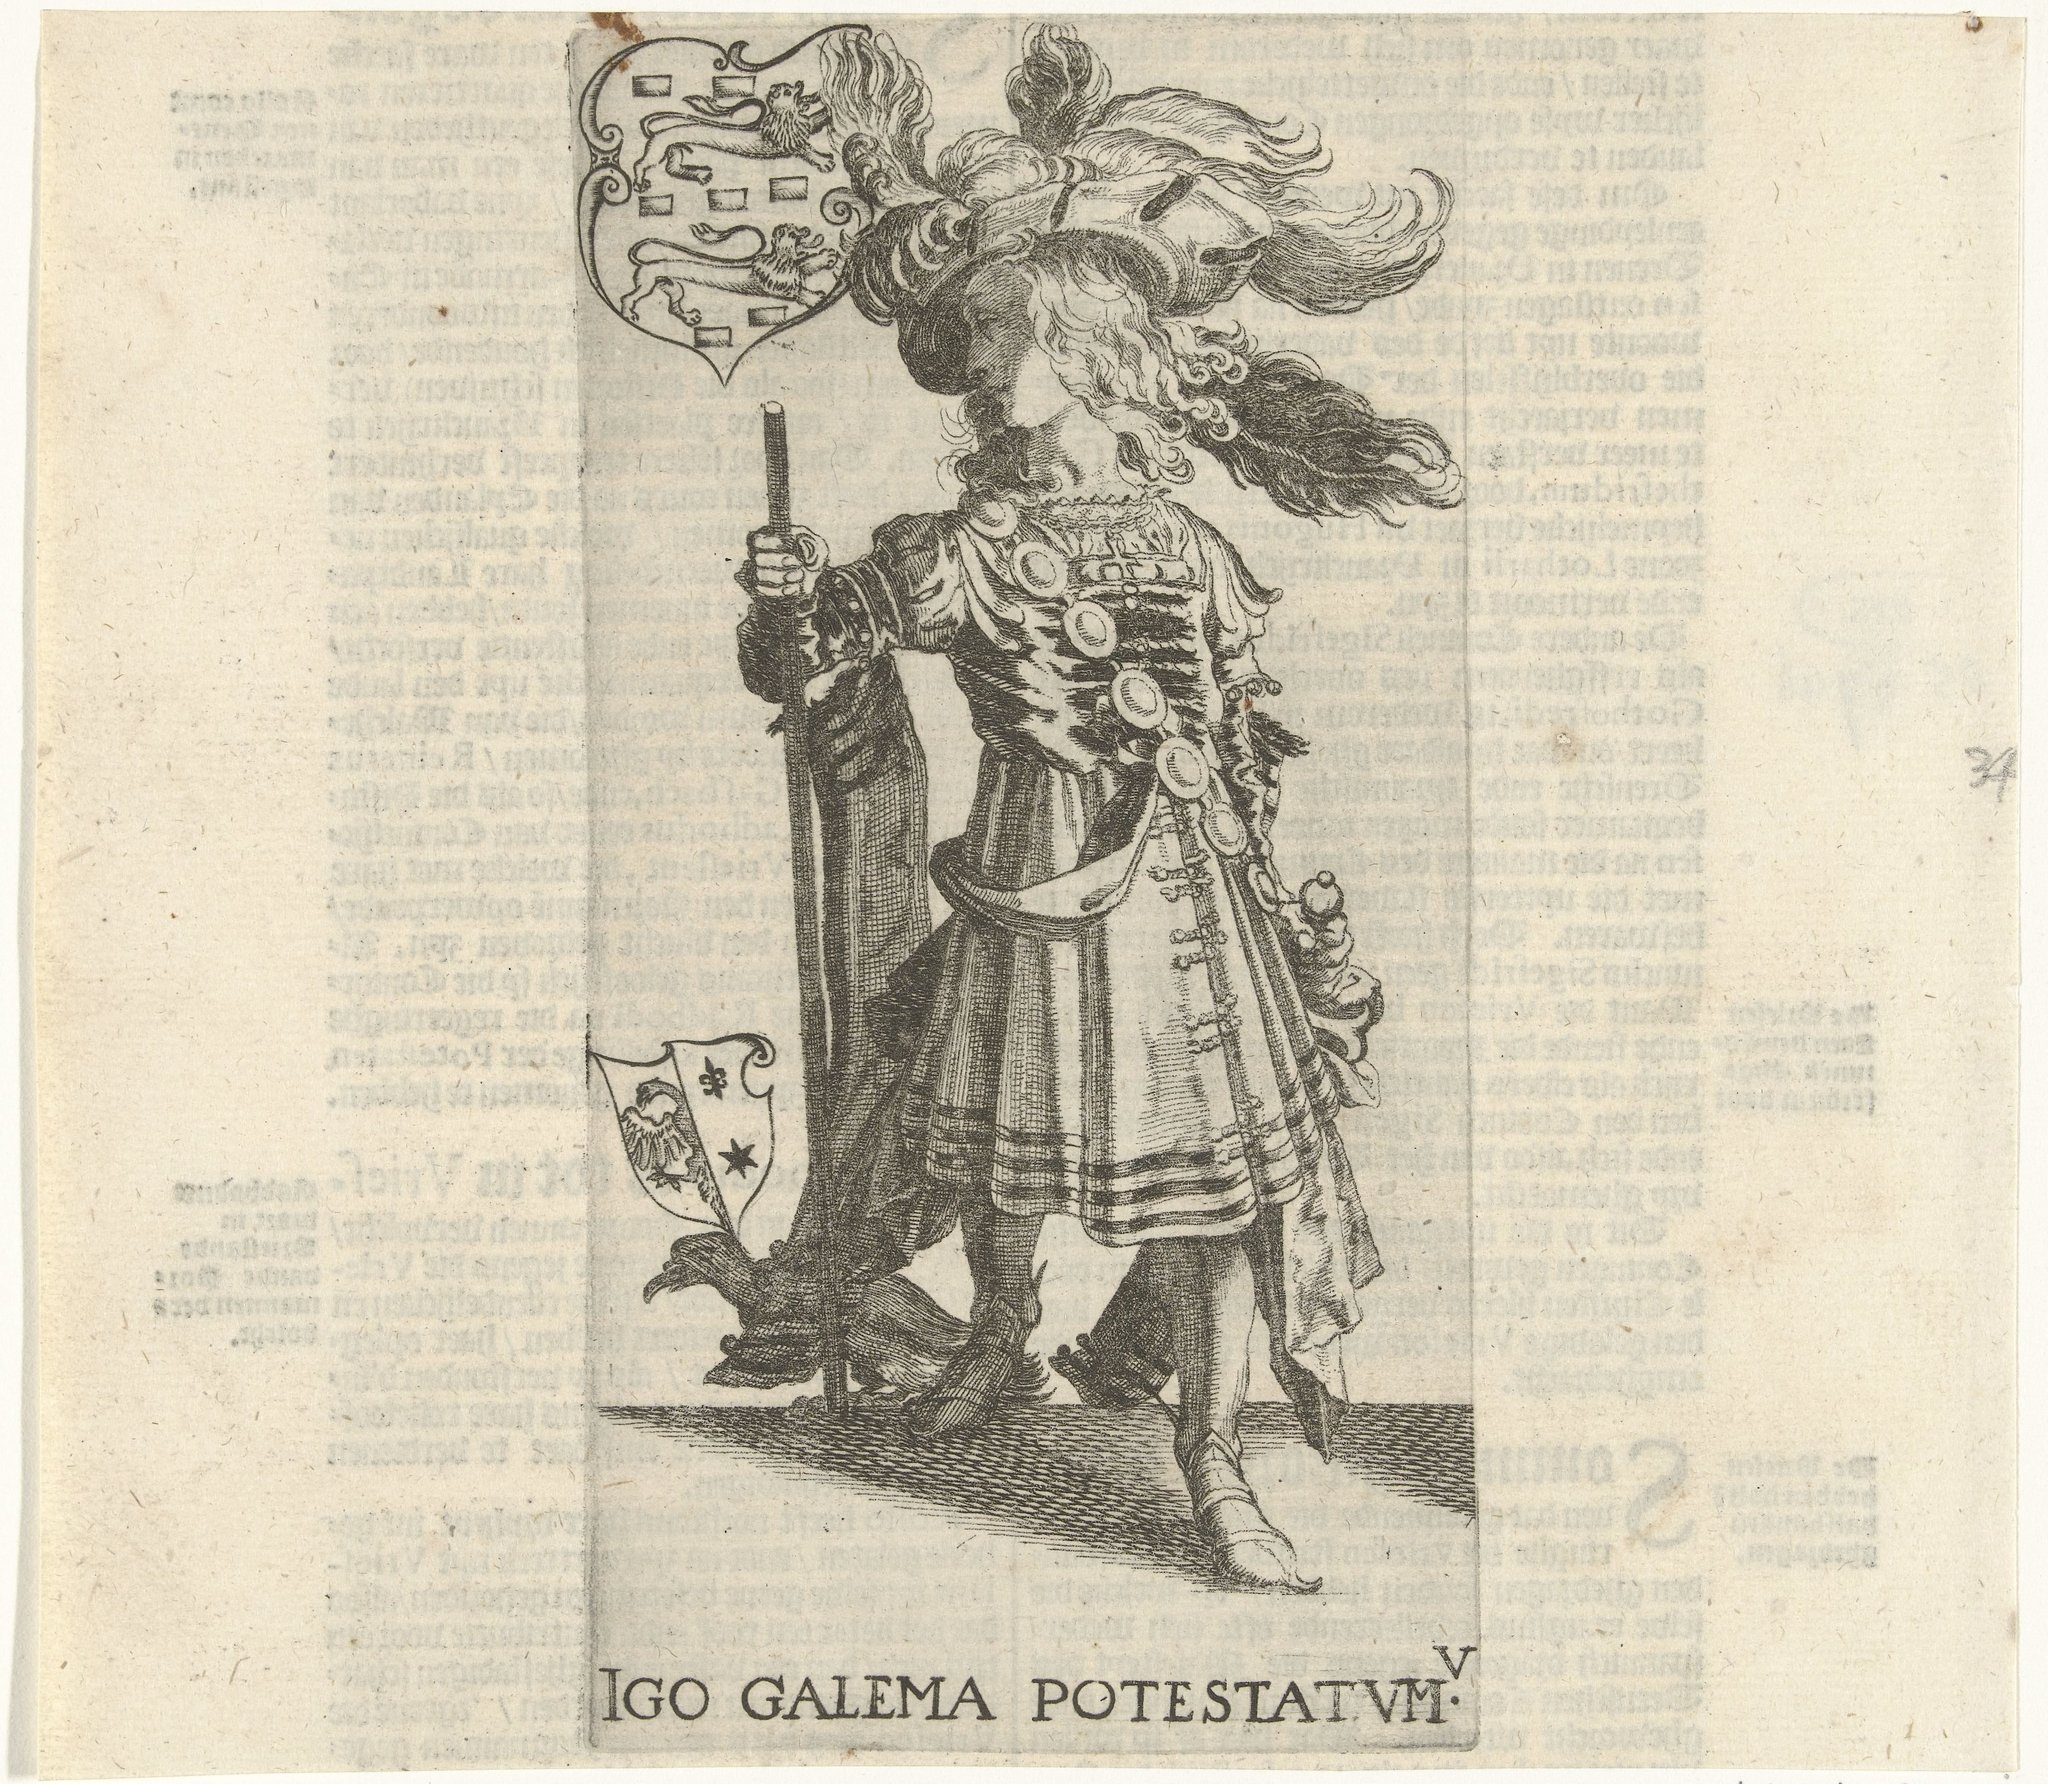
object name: print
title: Igo Galema potestatvm V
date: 1622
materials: paper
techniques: etching, letterpress printing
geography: northern netherlands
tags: igo galema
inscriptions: collector's mark: Lugt 2228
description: De prent is ook als boekillustratie gebruikt in: Winsemius, P.W. Chronique ofte Historische geschiedenisse van Vrieslant (...). Franeker: Joannes Lamrinck, 1622.